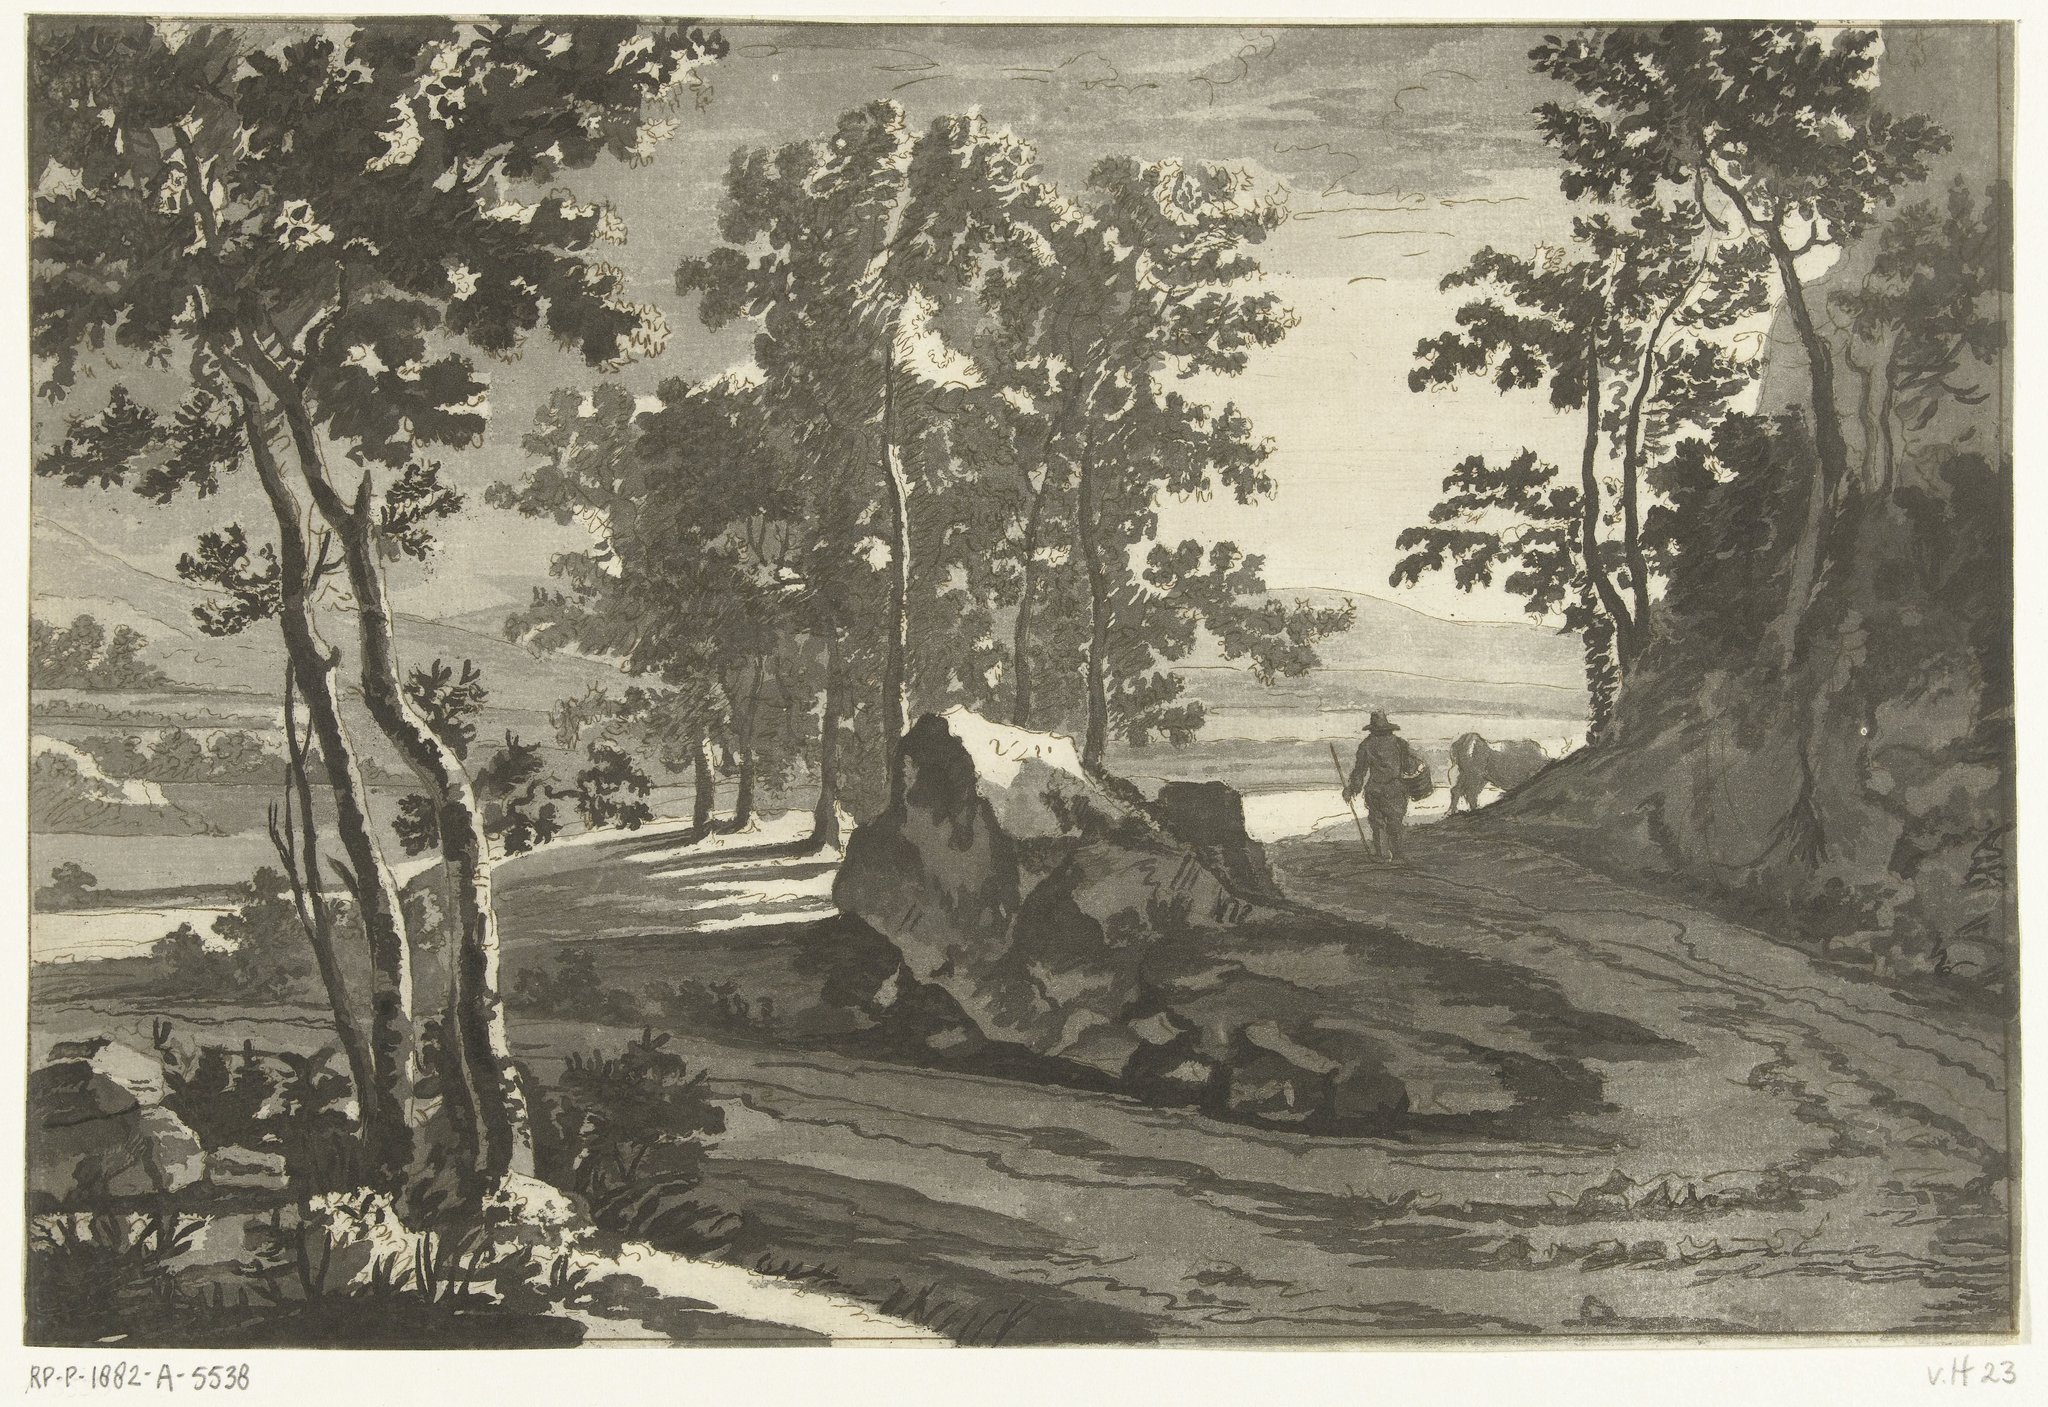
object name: print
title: Boomrijk landschap met veedrijver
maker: cornelis brouwer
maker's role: print maker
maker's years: 1731-1803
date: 1741-1803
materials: paper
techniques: aquatint, etching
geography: netherlands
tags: low hill country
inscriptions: collector's mark: Lugt 2228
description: Prent naar tekening van Jan Both gedrukt met twee platen. Prent uit serie van negen prenttekeningen met acht landschappen en een zeegezicht naar Hollandse meesters uit de 17e eeuw, zie Huffel 1921, p. 33-35.